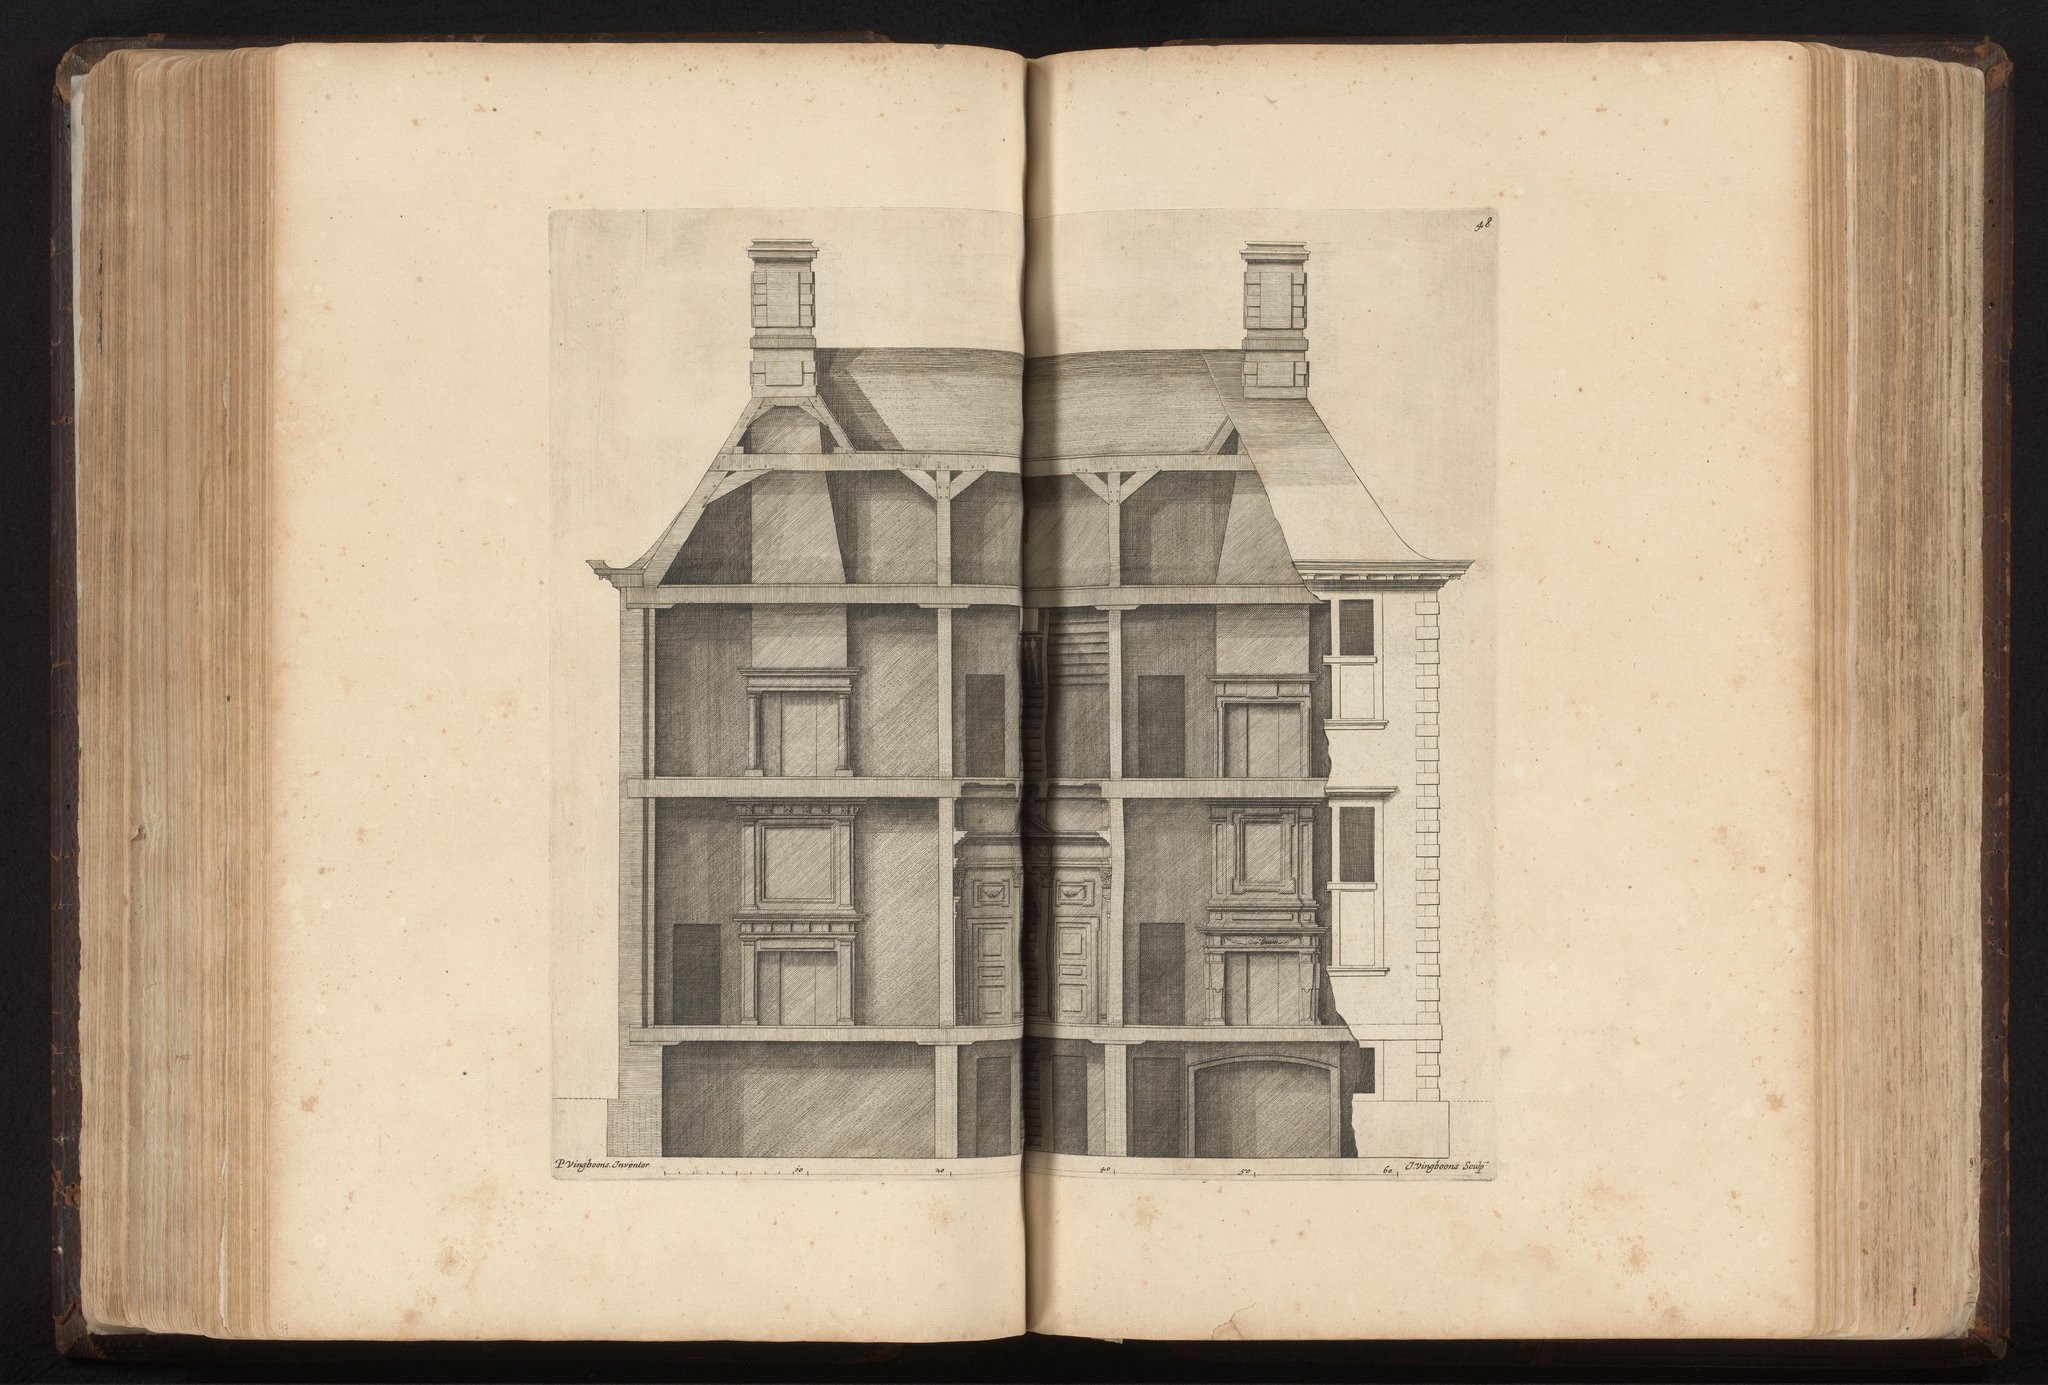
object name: book illustration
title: Doorsnede voor het landhuis Vredenburg in de Beemster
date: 1648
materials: paper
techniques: engraving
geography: amsterdam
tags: country-house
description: Prent uit: Afbeelsels der voornaemste gebouwen uyt alle die Philips Vingboons geordineert heeft. Amsterdam: Philips en Johannes Vinckboons en Johannes Willemszoon Blaeu, 1648.